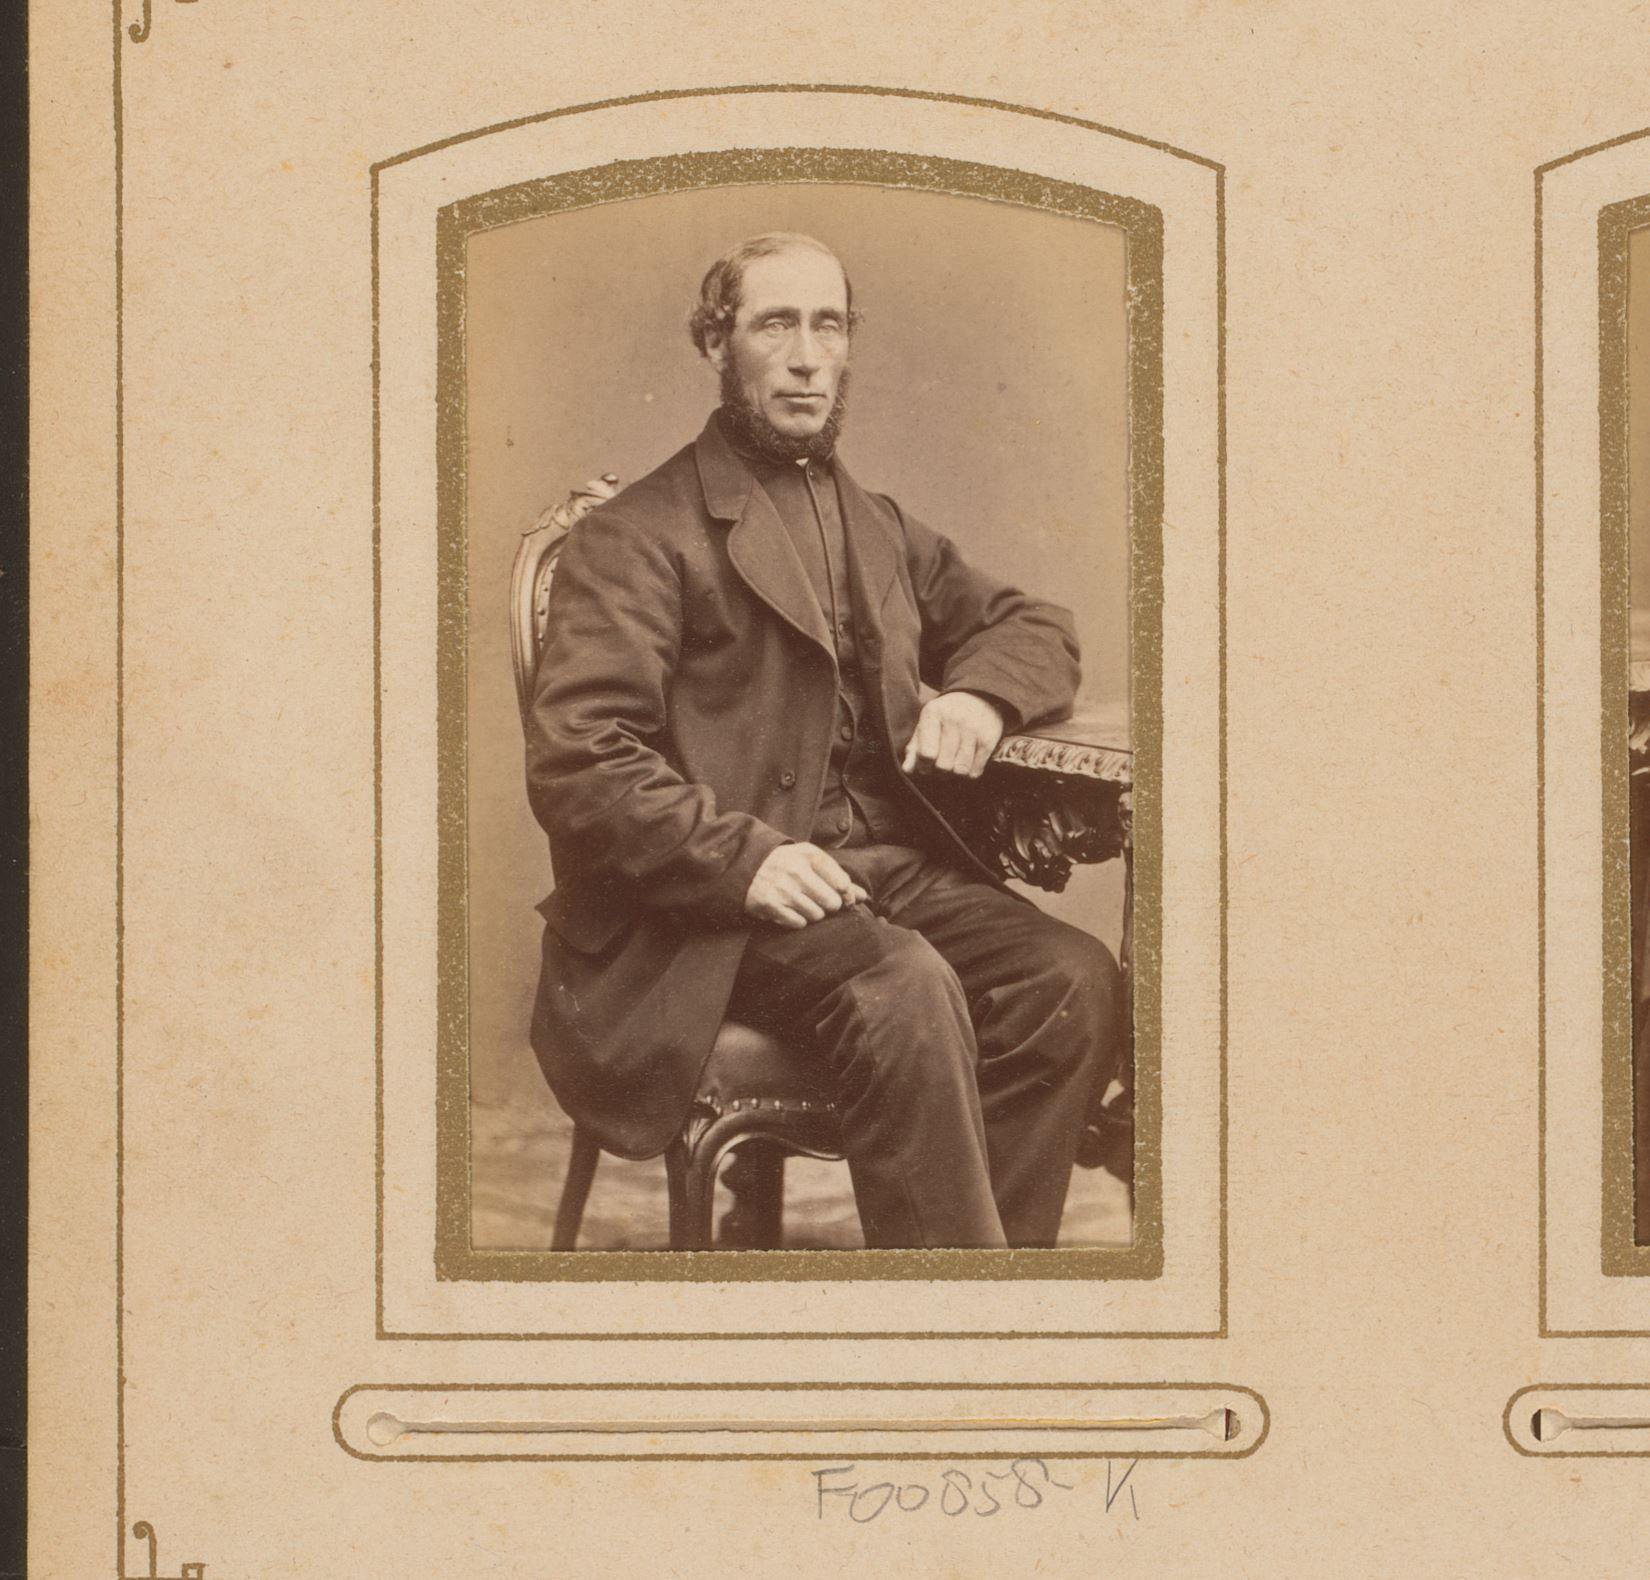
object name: carte de visite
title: Portret van een zittende man met baard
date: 1874-1884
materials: cardboard, photographic support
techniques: albumen print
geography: alkmaar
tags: historical persons, beard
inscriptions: inscription: ‘Alkmaar, Verdronken Oord; Helder, Kanaalweg tegenover Tivolie’